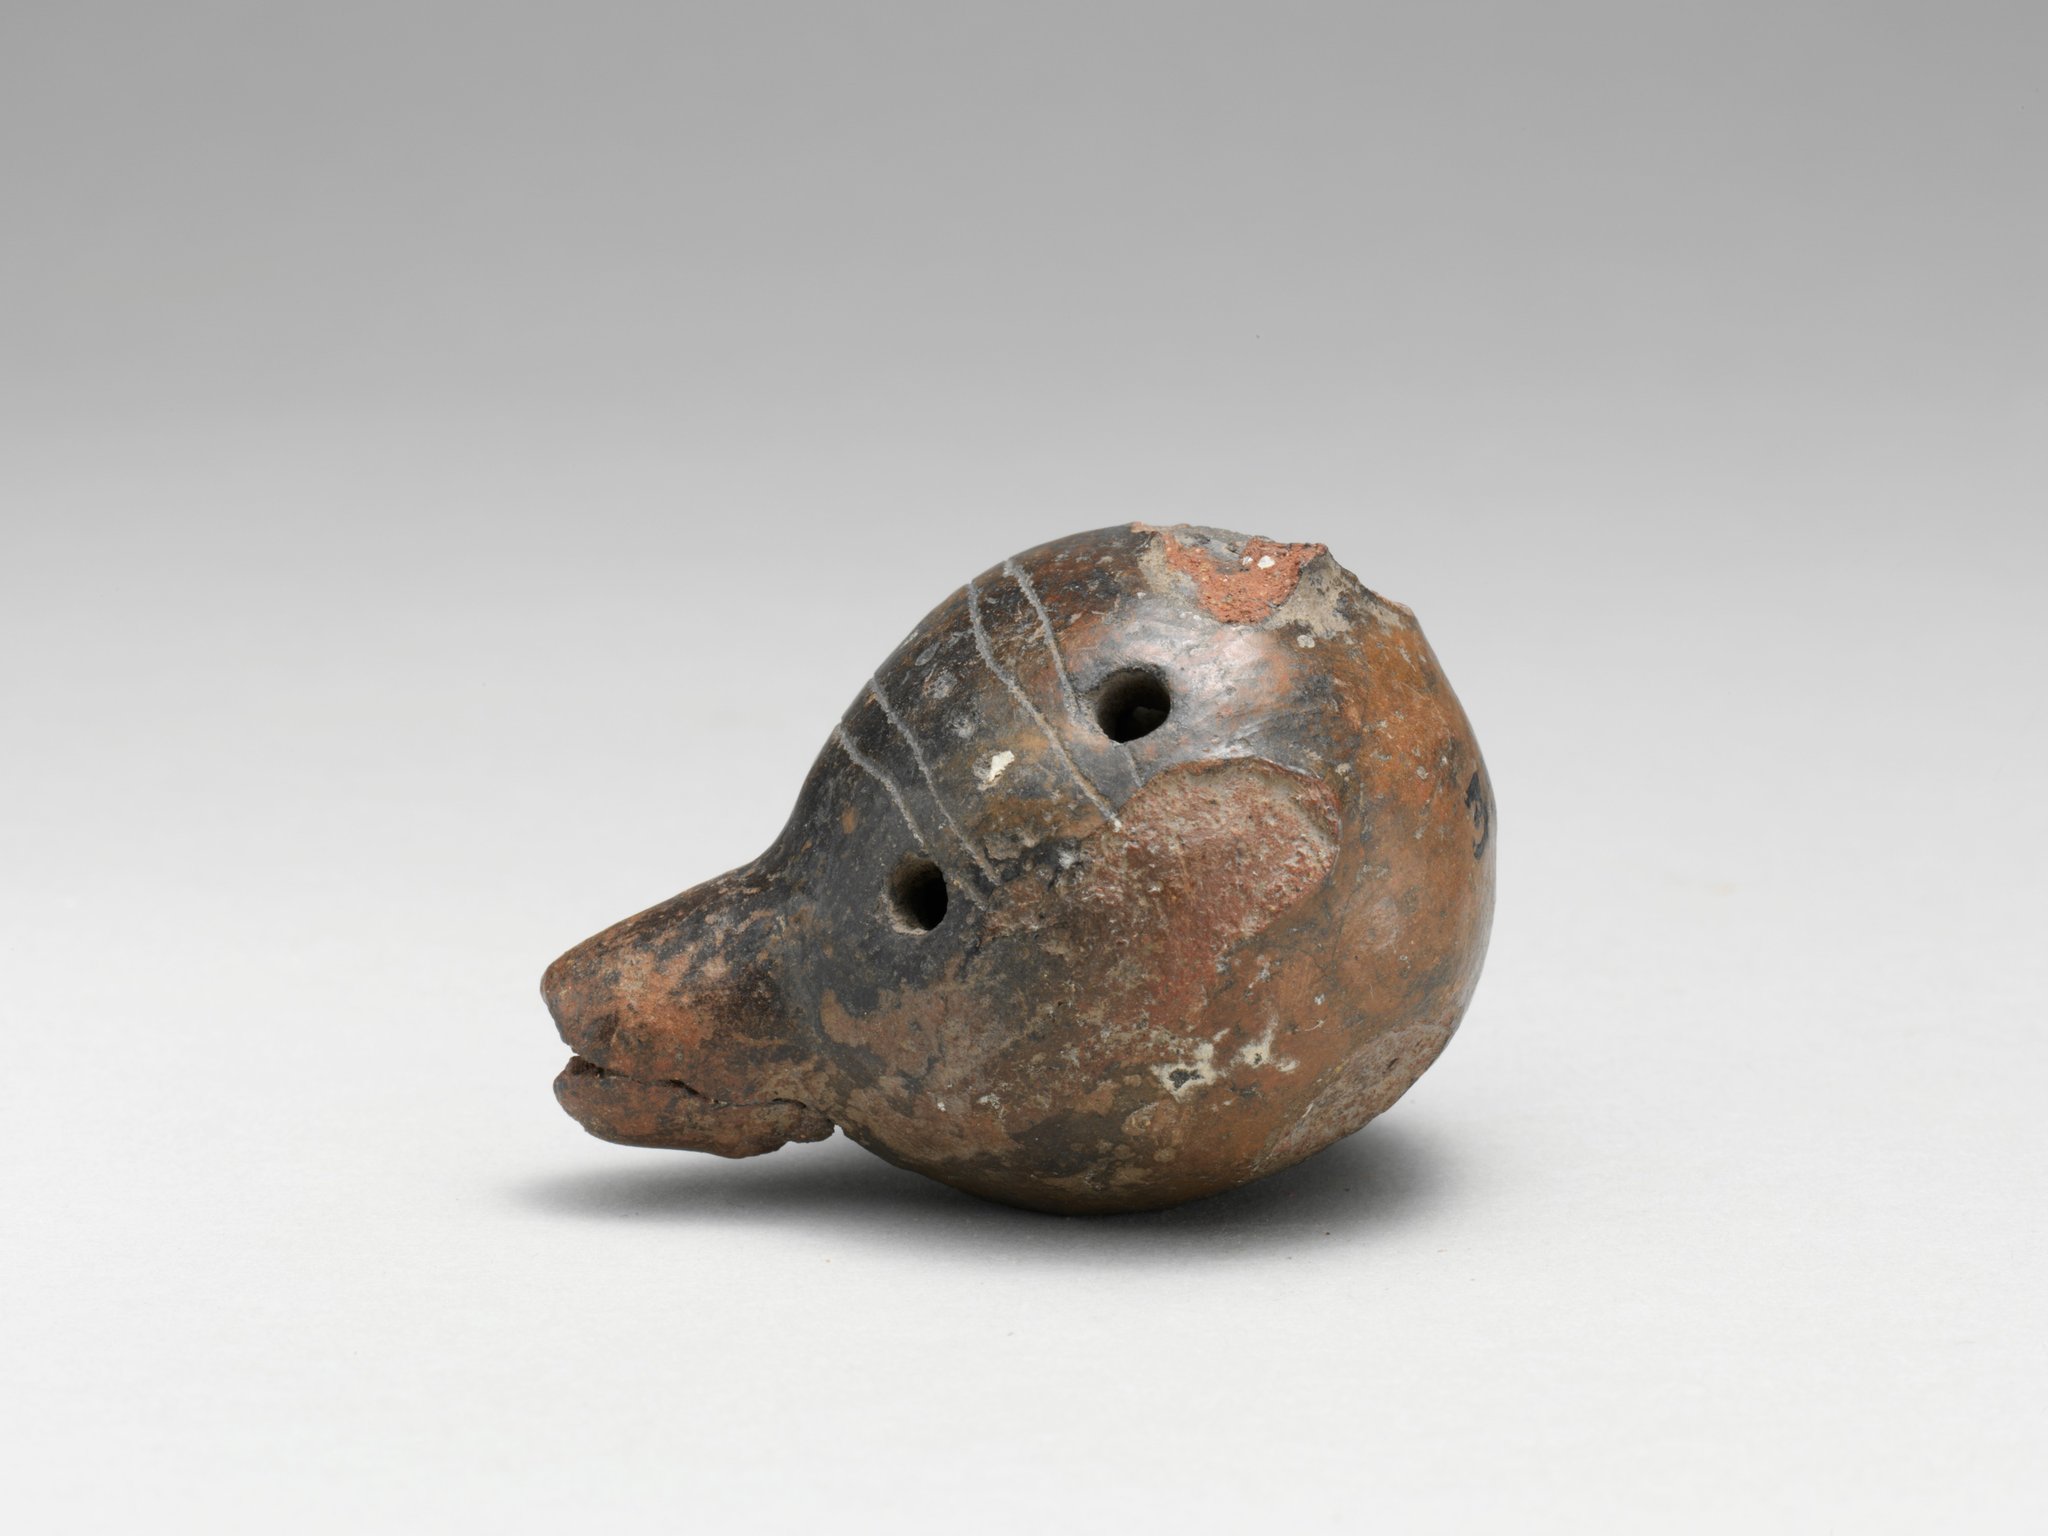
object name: pottery whistle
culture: costa rican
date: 800-1500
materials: clay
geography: costa rica